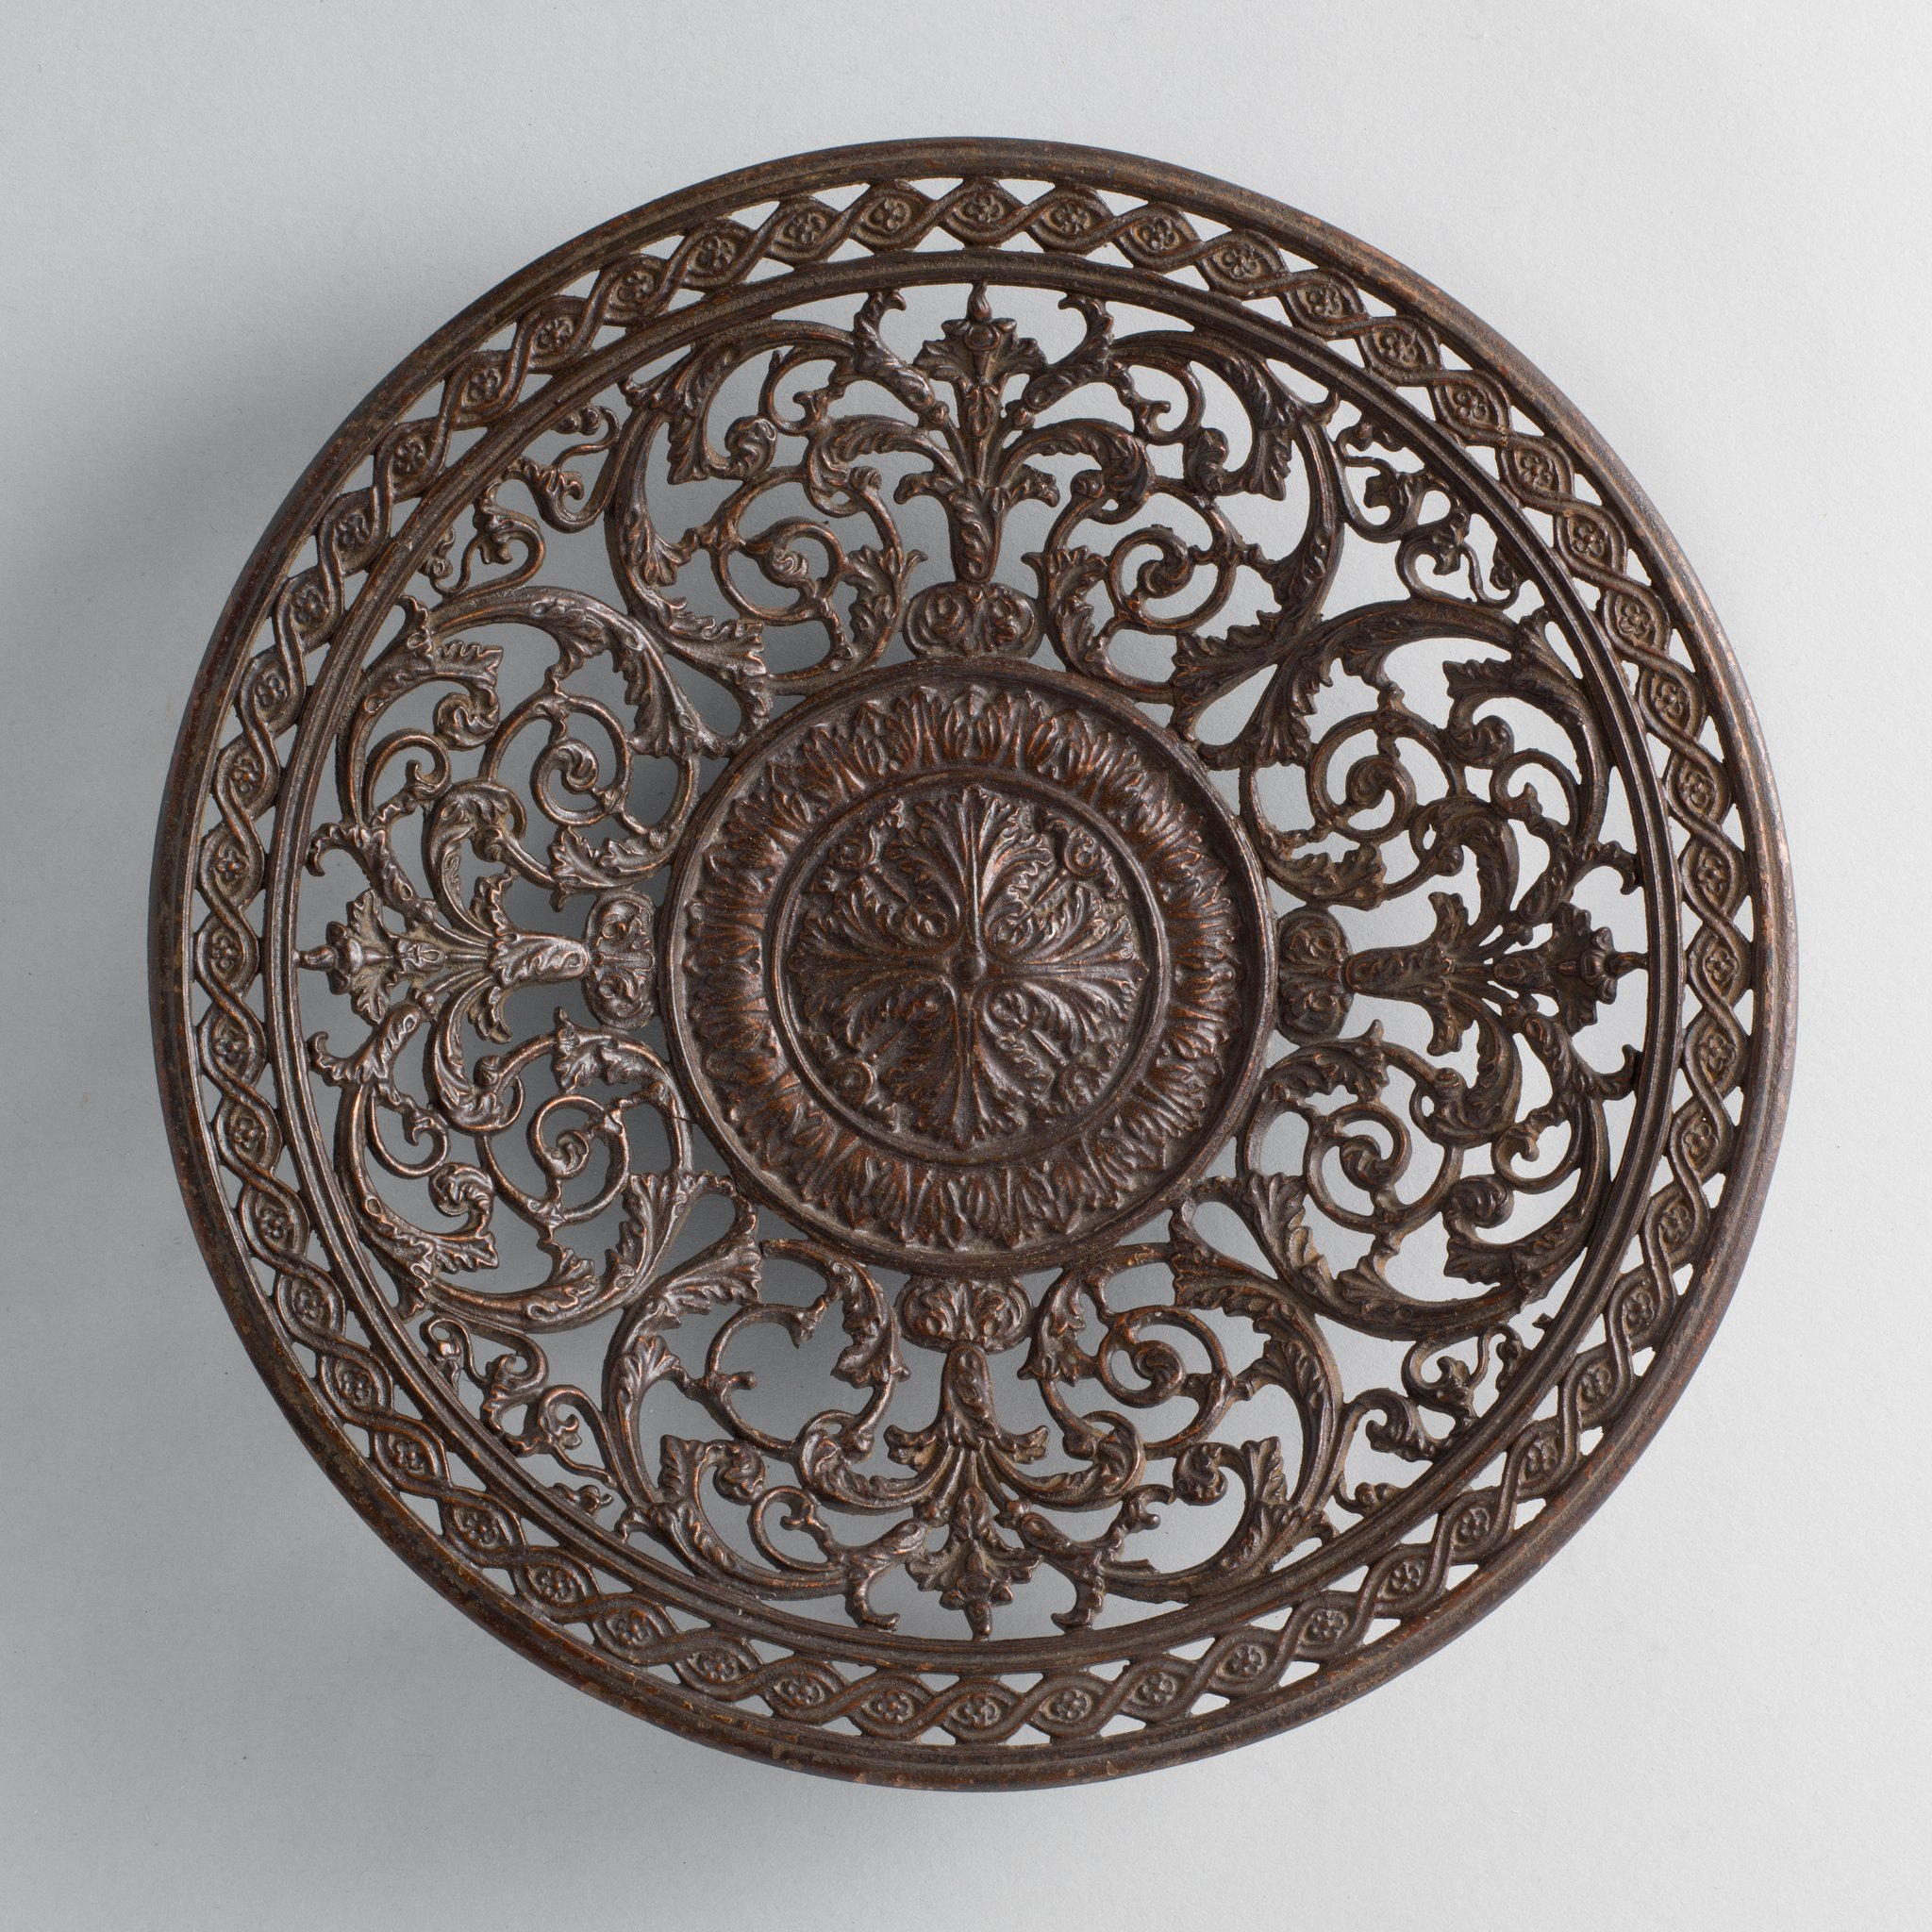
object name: dish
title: Fruit dish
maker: coalbrookdale company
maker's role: maker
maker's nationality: british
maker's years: 1709-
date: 1860-1880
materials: iron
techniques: casting